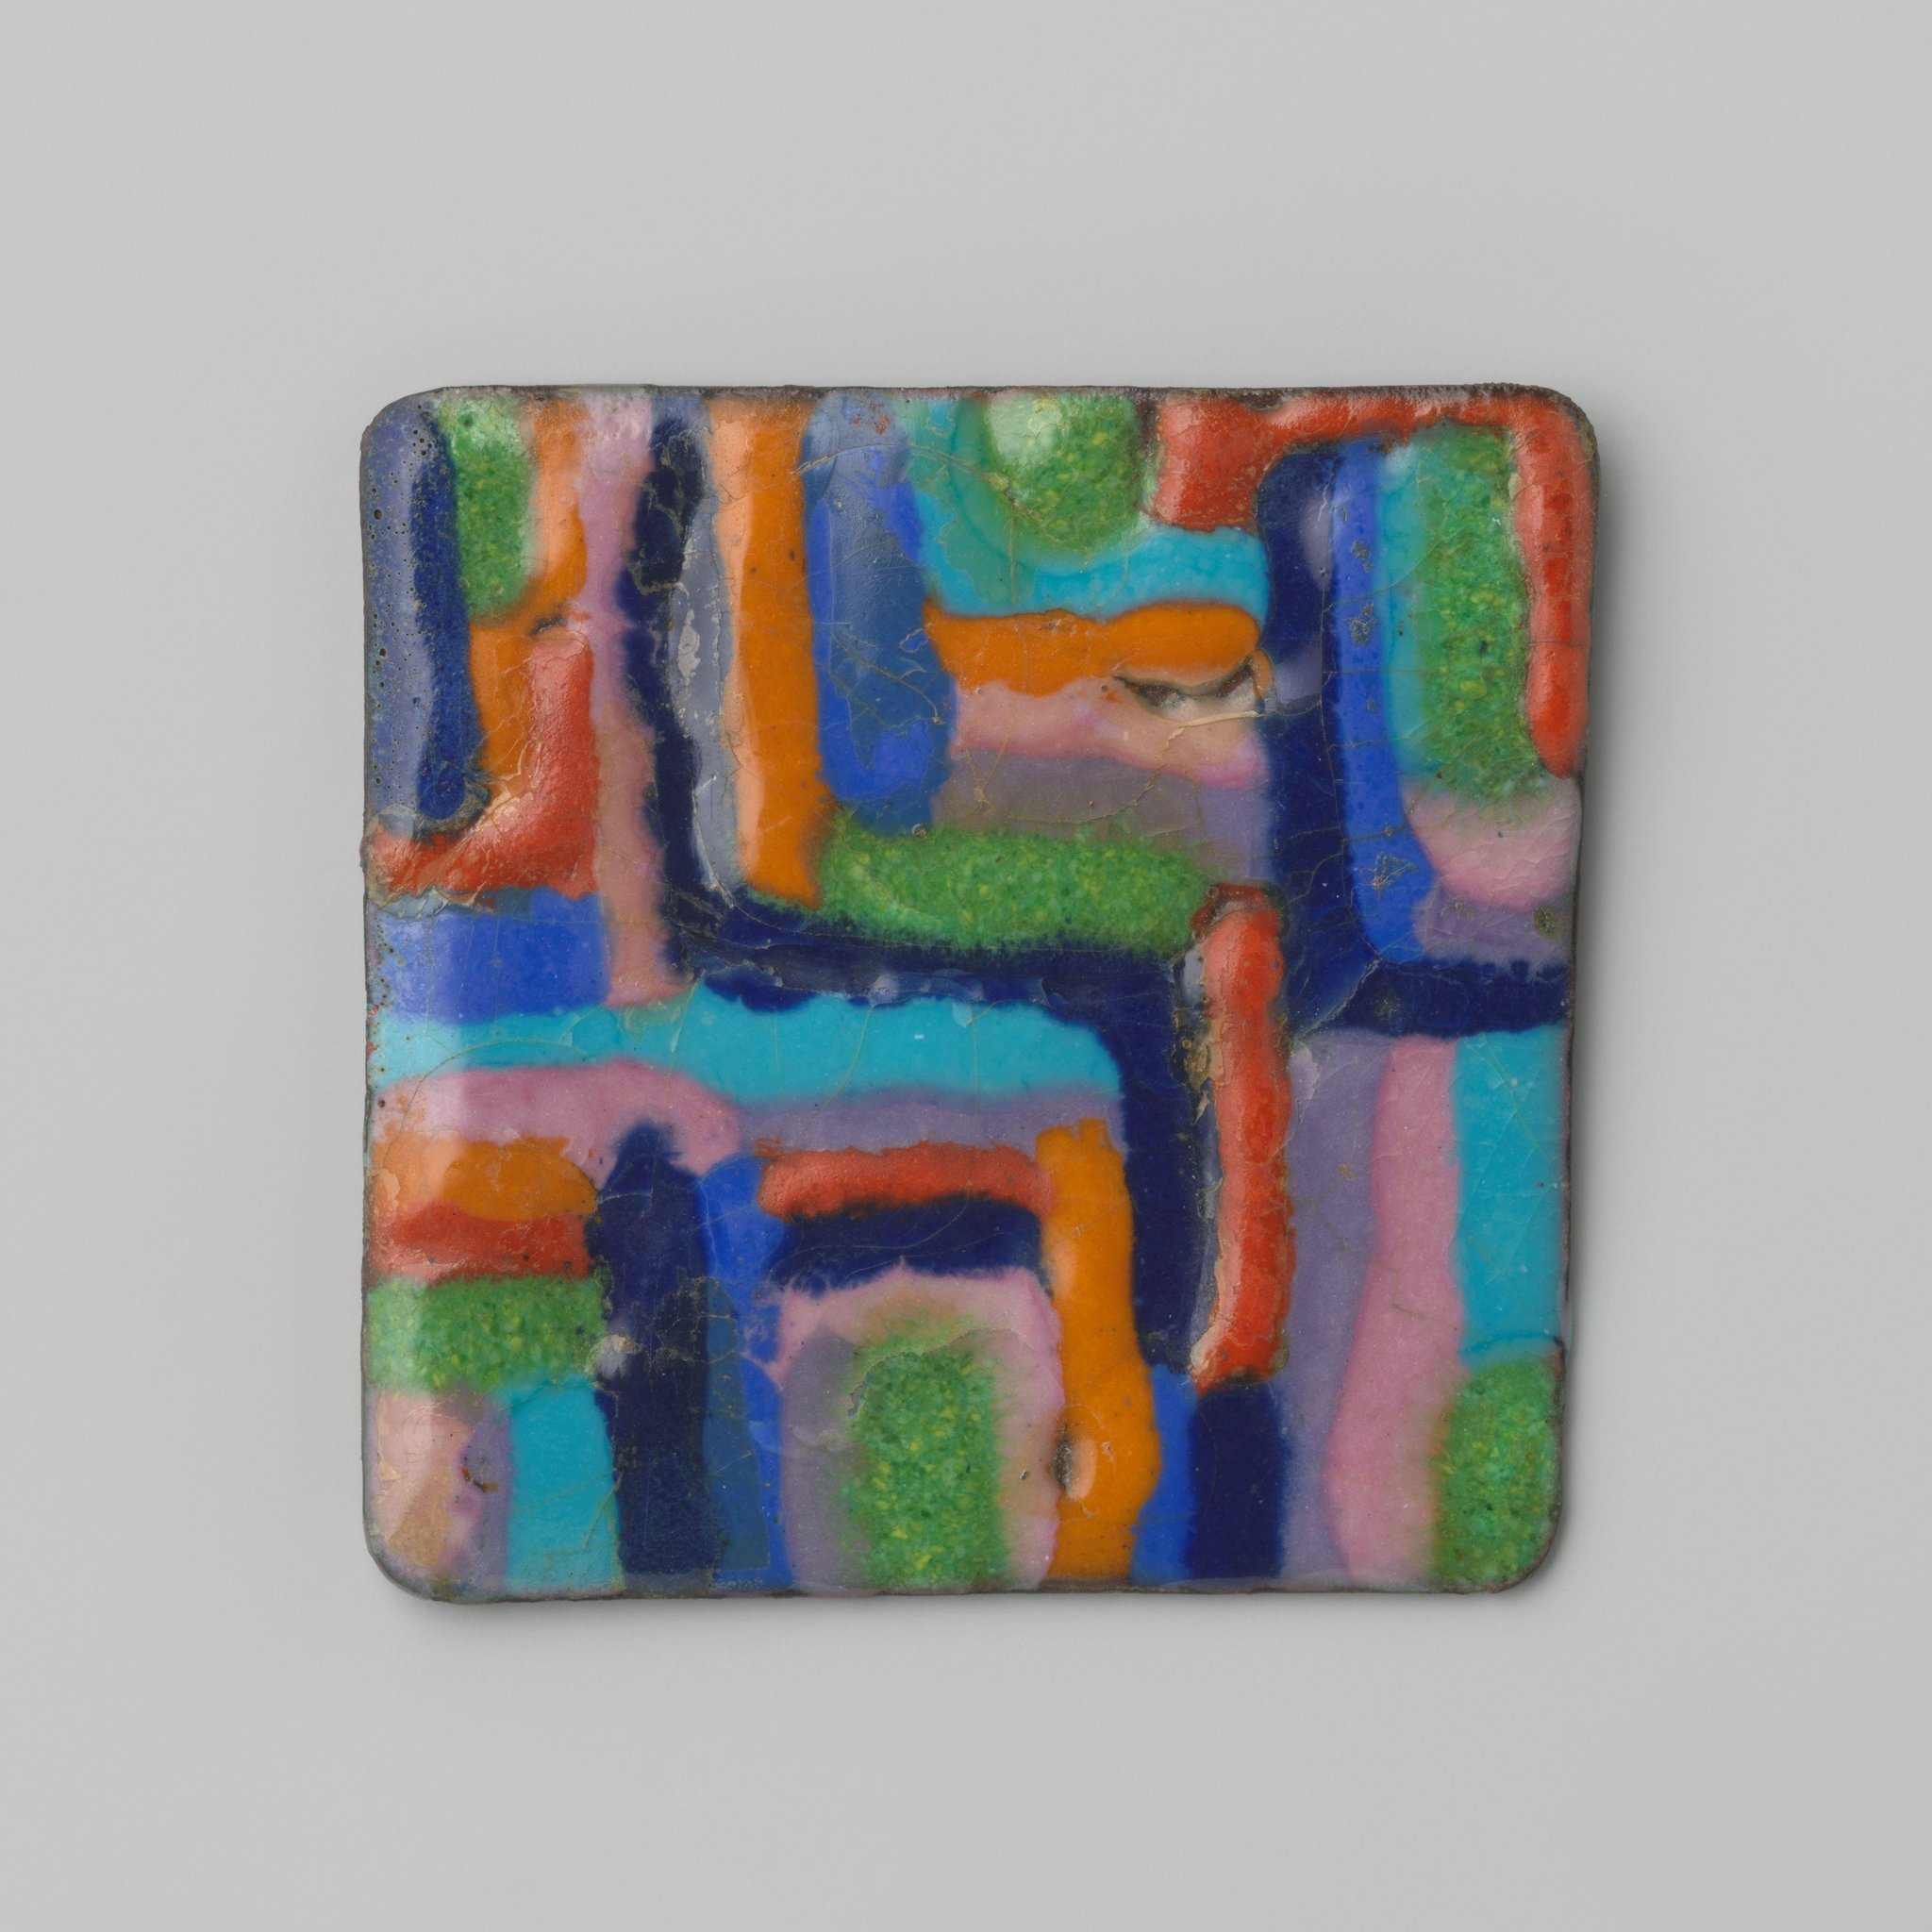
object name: plate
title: Vierkant plaatje van email op koper met abstract-geometrische decoratie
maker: Anonymous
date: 1950-1960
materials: copper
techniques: enameling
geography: netherlands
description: Vierkant plaatje met afgeronde hoeken van email op koper met abstract-geometrische decoratie in blauw, groen, rose en oranje.